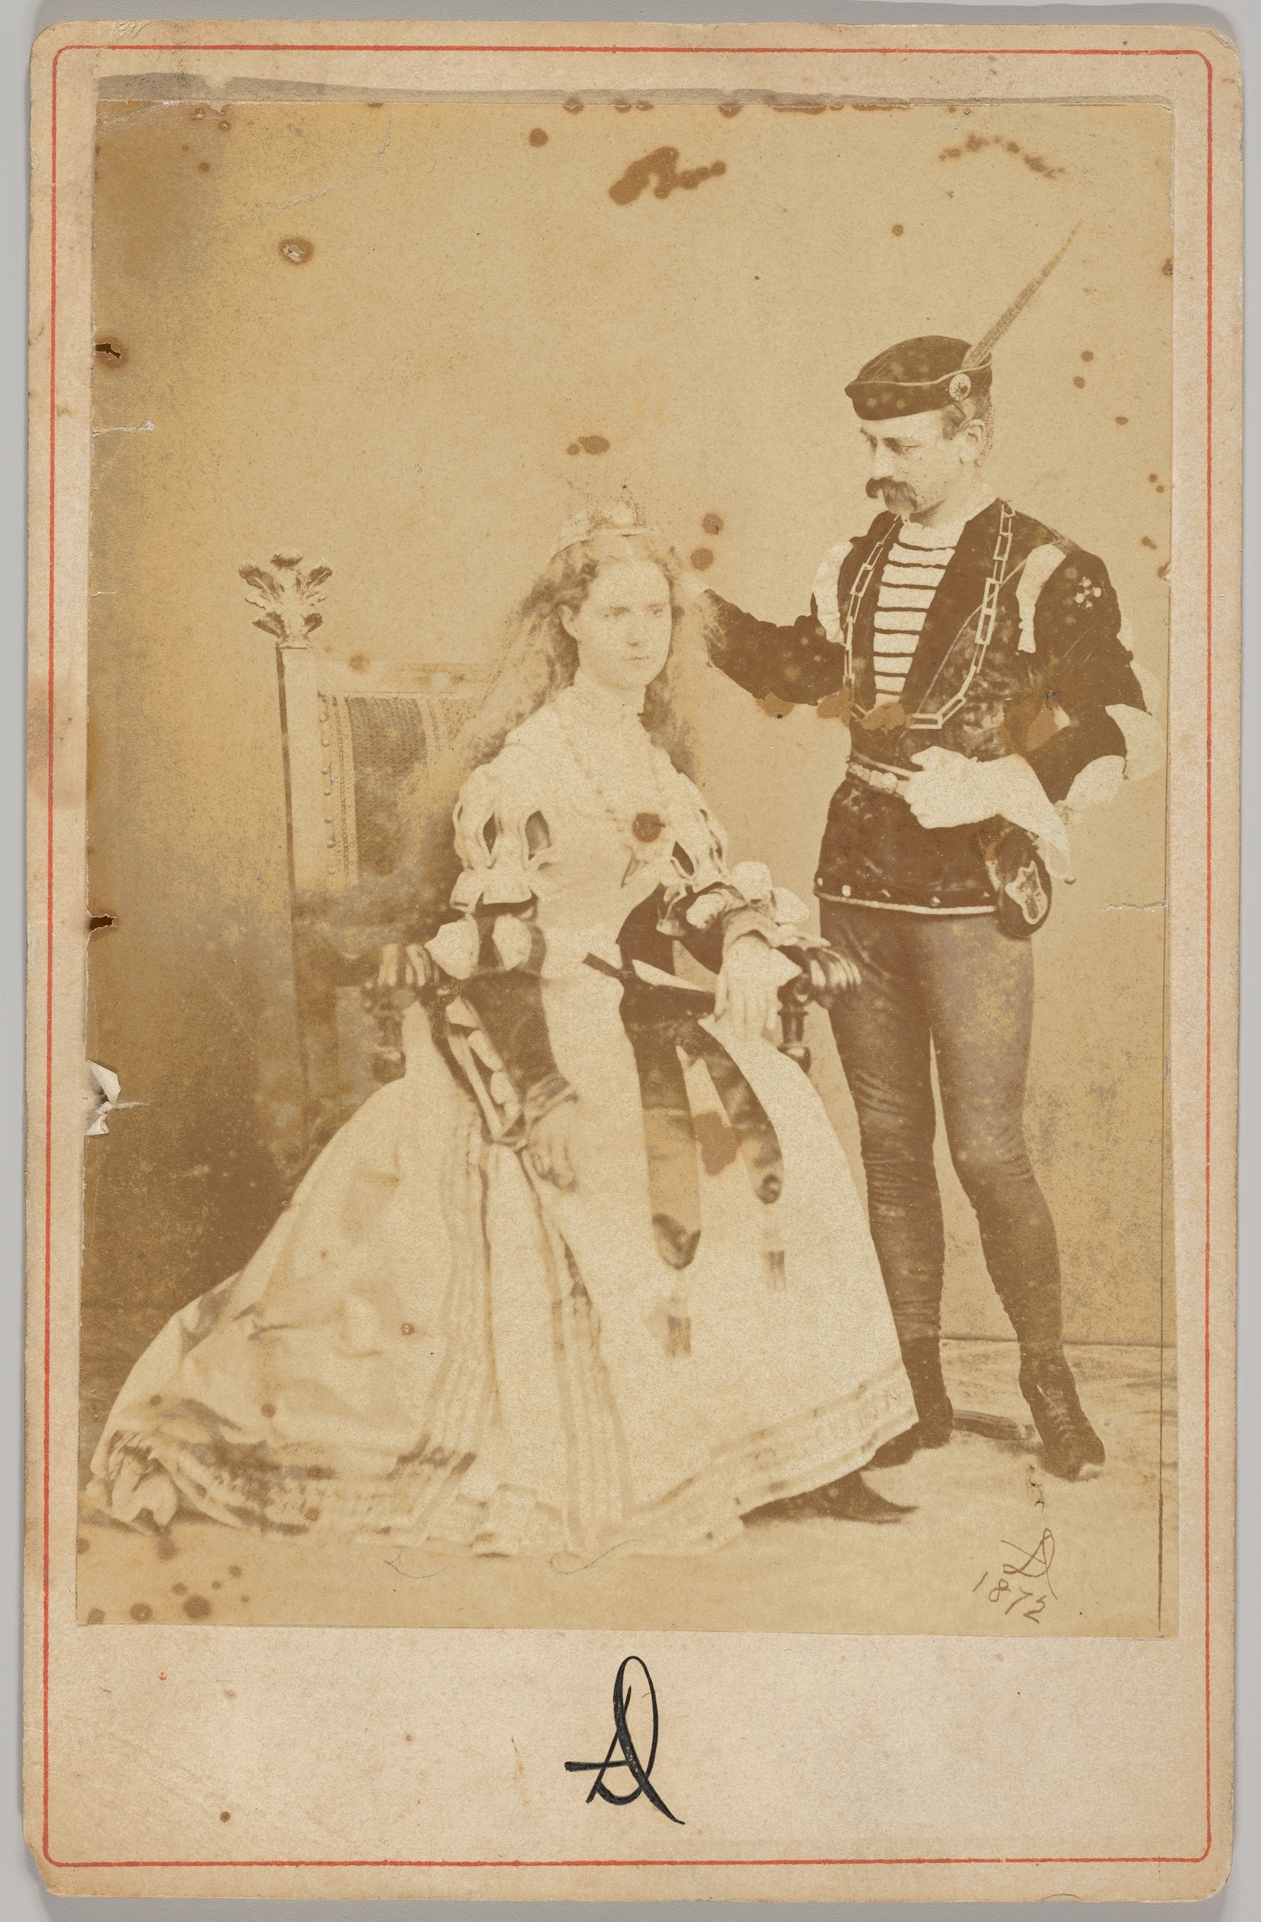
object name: photograph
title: David Maitland Armstrong and Helen Neilson Armstrong in 15th-century Style Fancy Dress in Rome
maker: anonymous, italian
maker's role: artist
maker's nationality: italian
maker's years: 1400-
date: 1871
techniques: photography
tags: men,portraits,women